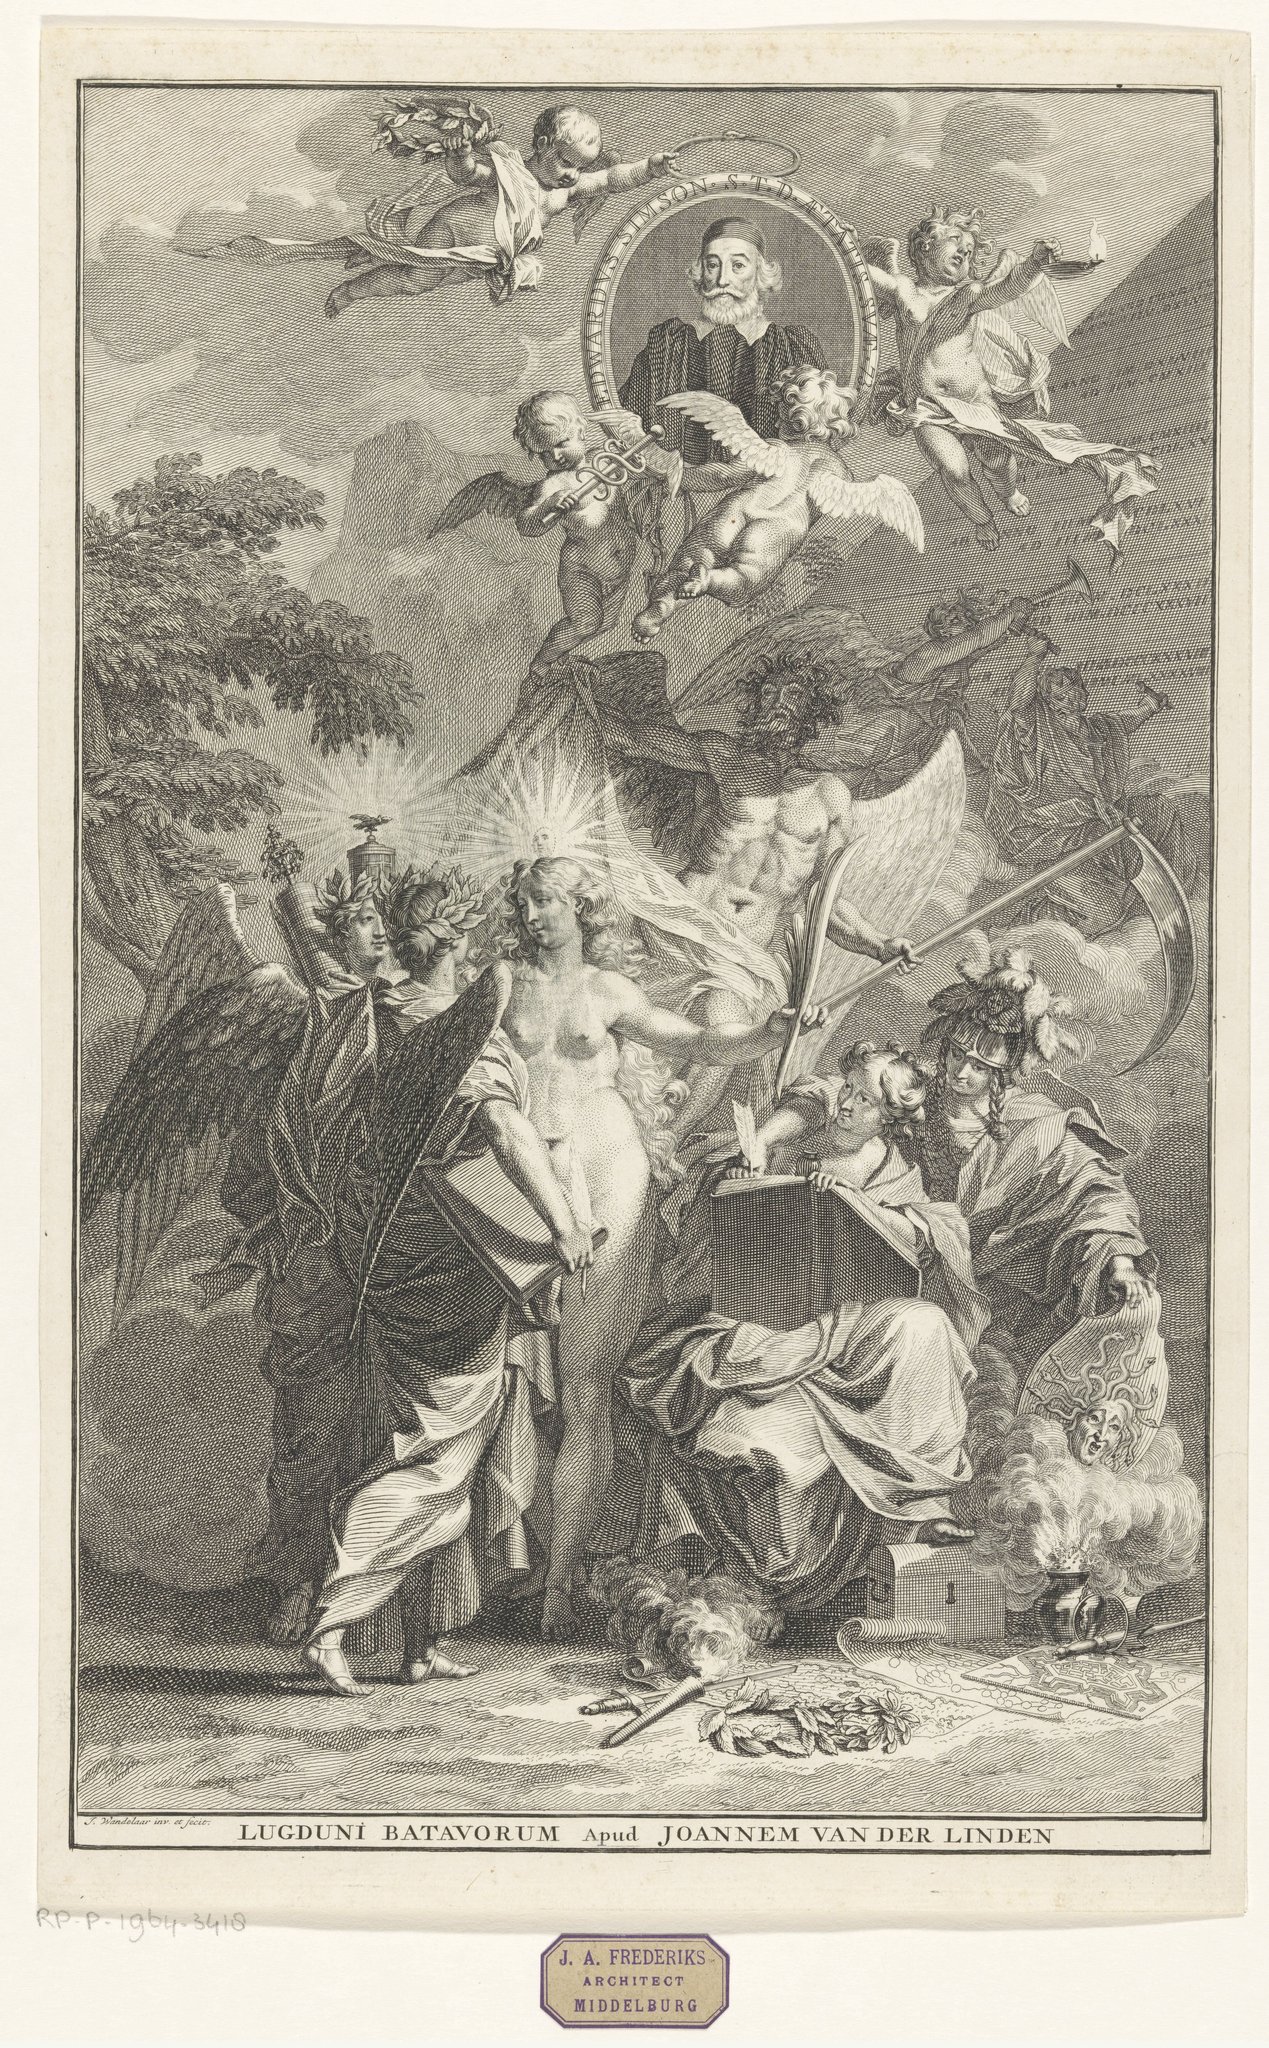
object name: titelblad, titelpagina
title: Titelpagina voor: Edward Simson, Chronicon historiam catholicam complectens, 1729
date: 1729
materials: paper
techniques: engraving, etching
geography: leiden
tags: (story of) minerva (pallas, athena), eternity, 'aeternitas'; 'eternità','eternità o perpetuità' (ripa), symbolic representations, allegories and emblems ~ poetry; 'poesia' (ripa), 'historia'; 'historia' (ripa), father time, man with wings and scythe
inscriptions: collector's mark: ‘J.A. Frederiks Architect Middelburg’, collector's mark: Lugt 2228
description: Minerva zit naast Geschiedenis en kijkt over haar schouder mee naar het boek waarin zij schrijft. Geschiedenis kijkt op naar drie allegorische vrouwfiguren (Waarheid, Poëzie en een derde figuur). Achter hen Vader Tijd, Faam en een tweehoofdige figuur die met een beitel een inscriptie slaat in een piramide. In de lucht vliegen vier putti, met eeuwigheidsymbolen in de handen, die het portret van schrijver Edward Simson meevoeren.